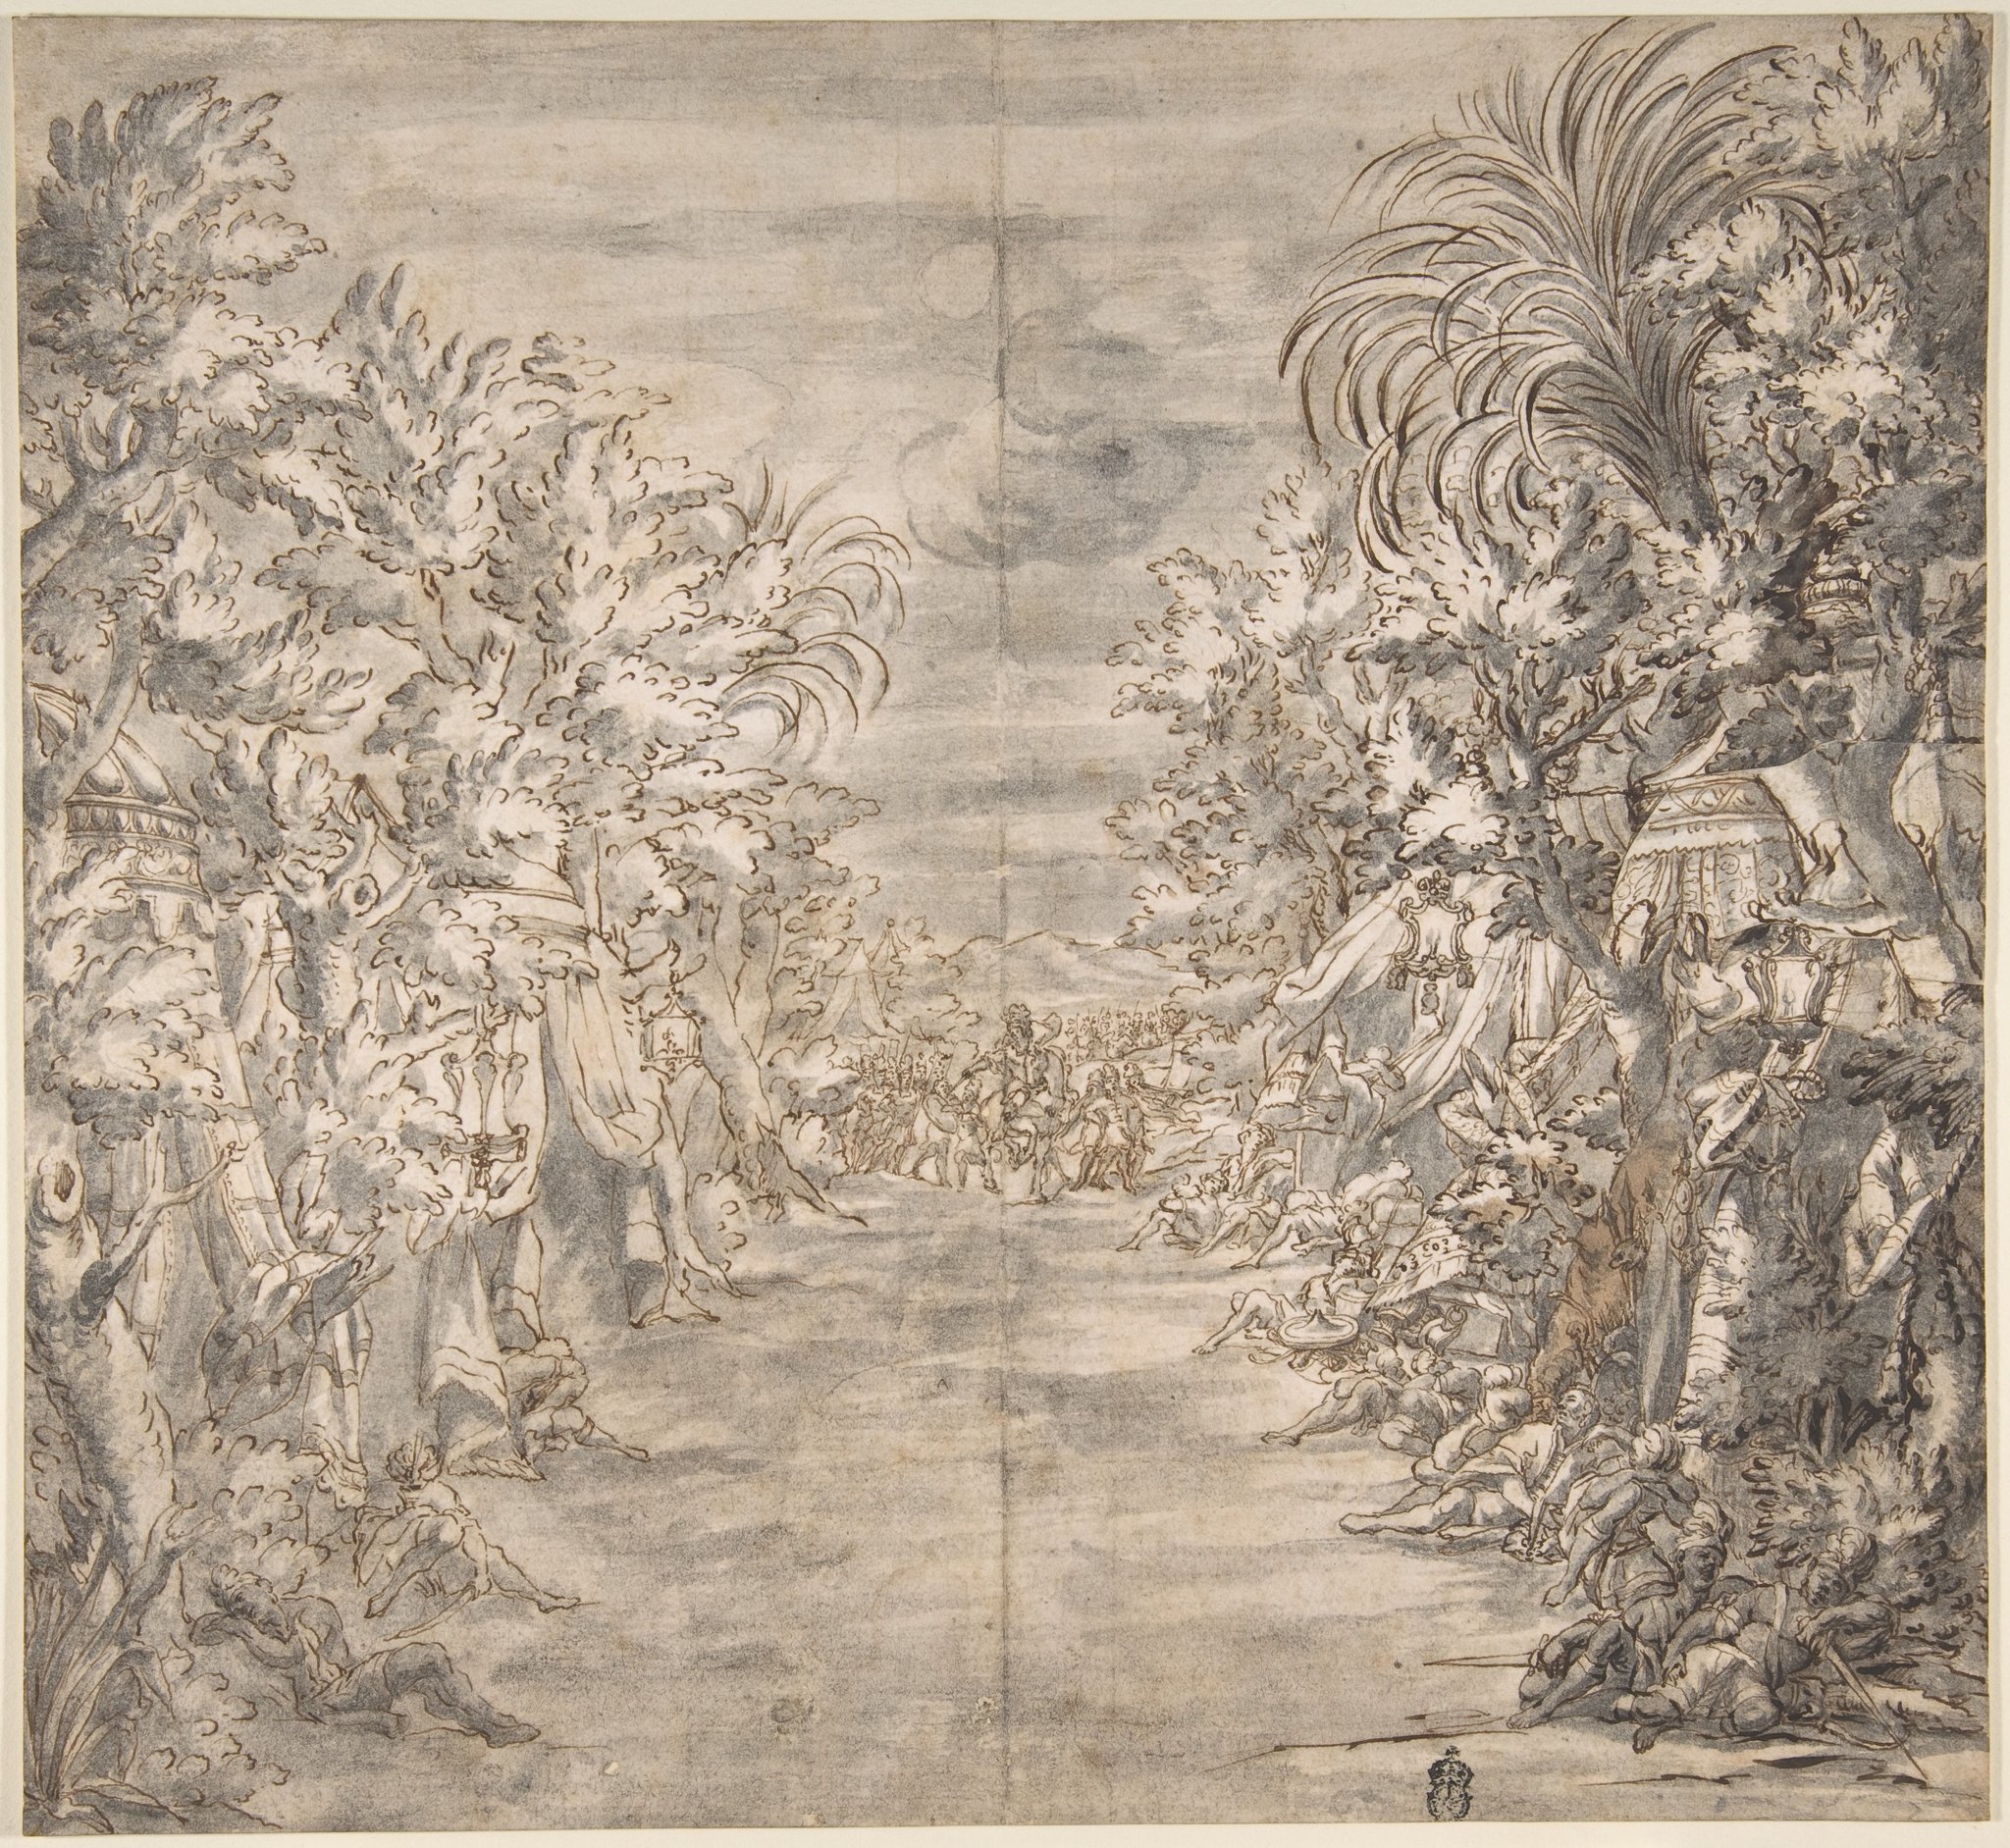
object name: drawing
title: Ornamental Theater Scene with Trees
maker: anonymous, italian, 17th or 18th century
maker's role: artist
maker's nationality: italian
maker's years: 1600-1799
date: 1601-1800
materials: ink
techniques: brush, pen, wash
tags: human figures,theatre,trees